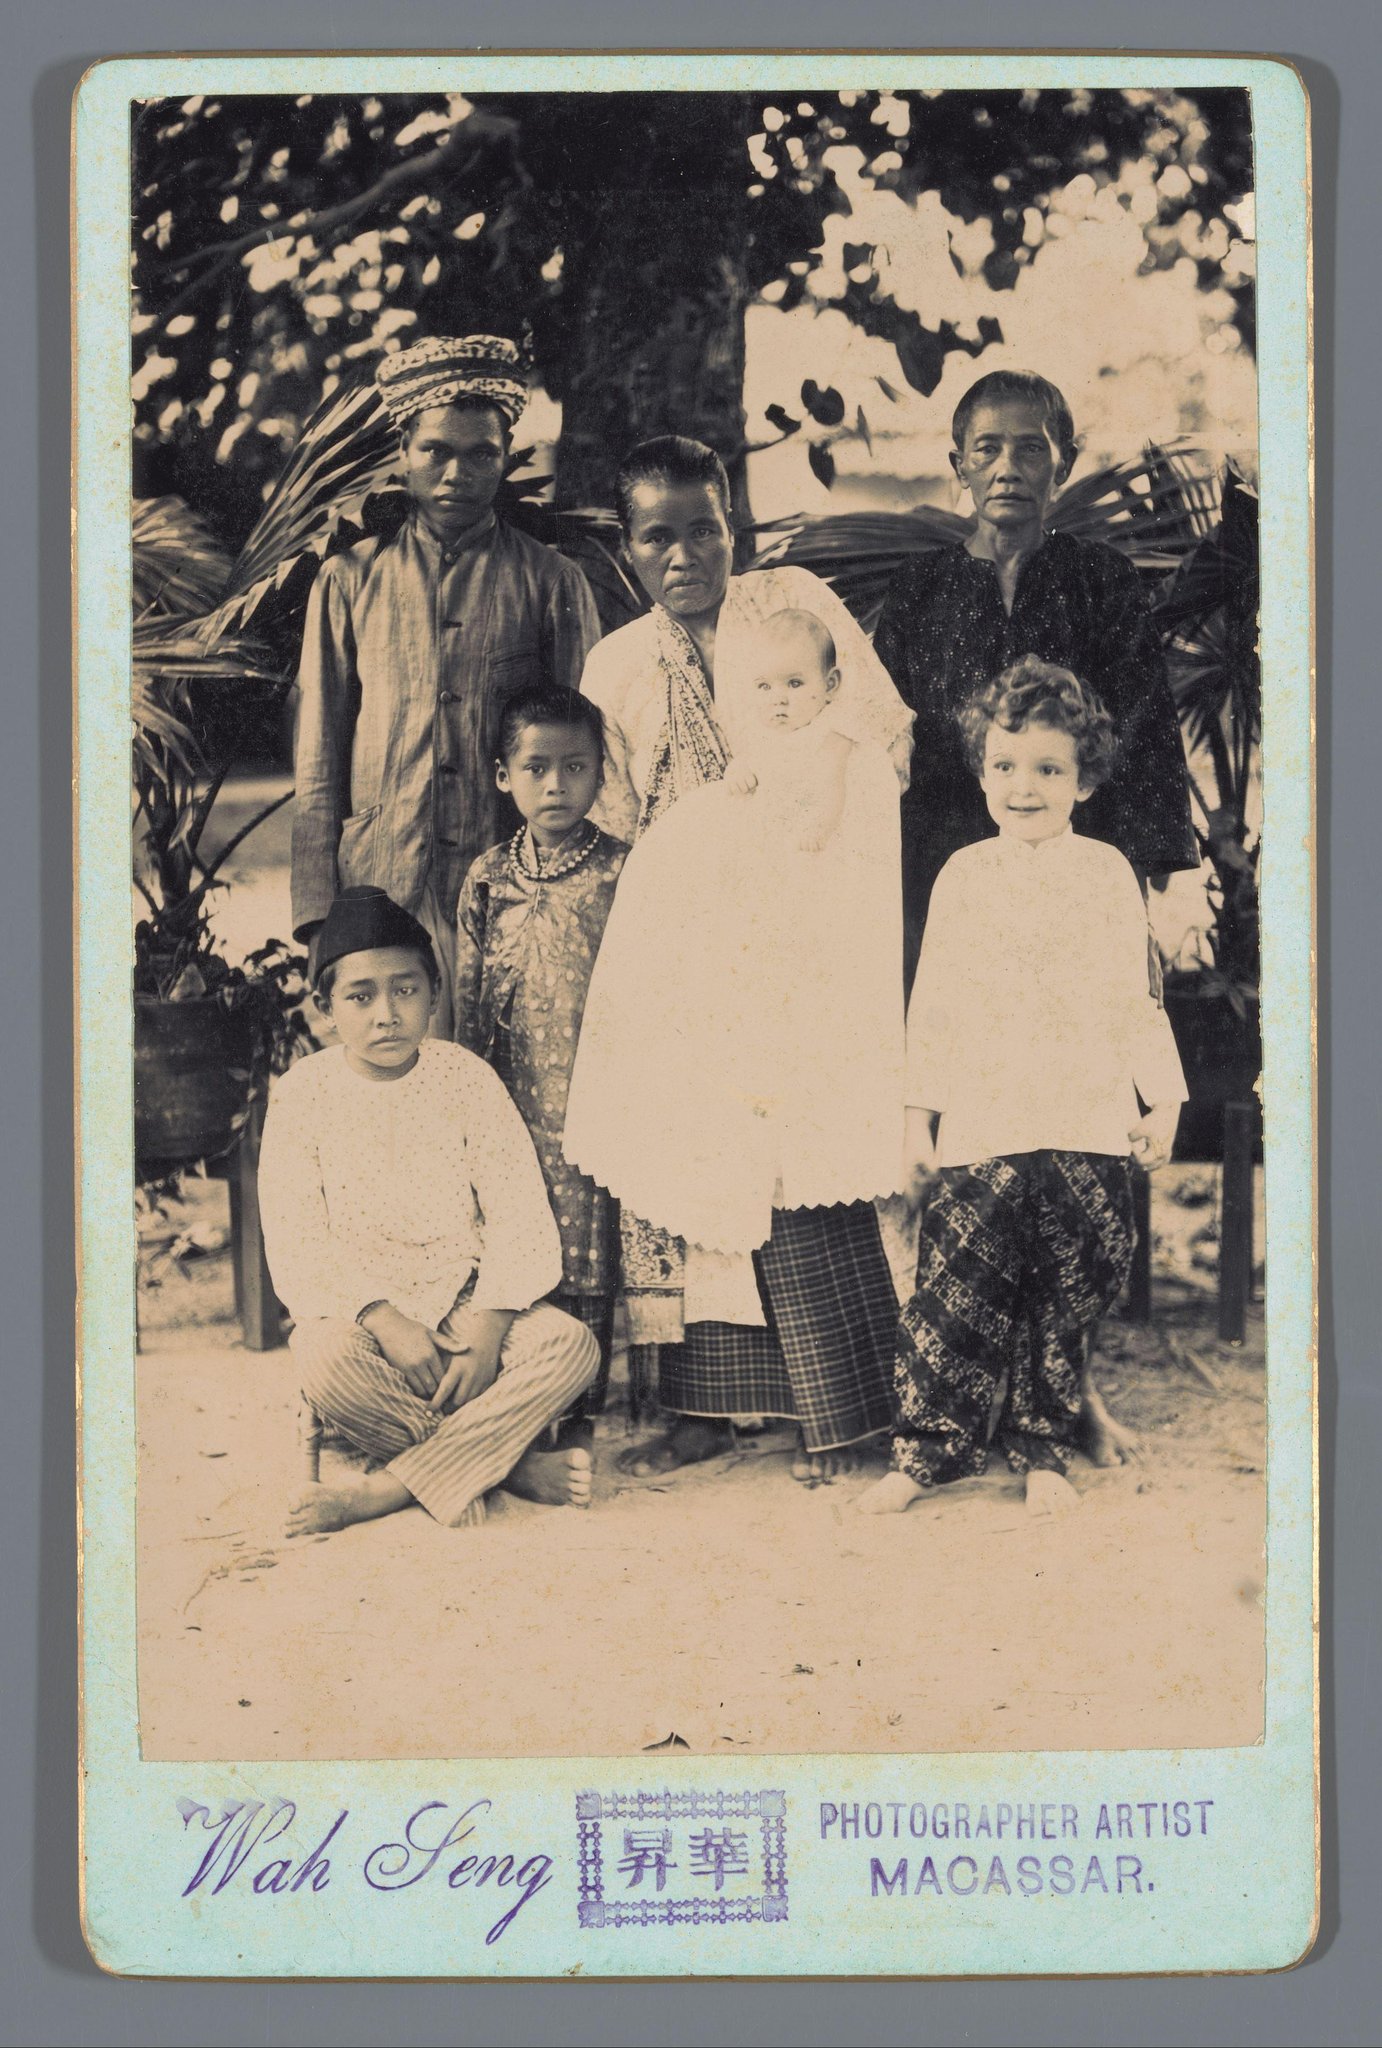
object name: cabinet photograph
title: Portret van een onbekende Indische familie en twee onbekende Westerse kinderen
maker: wah seng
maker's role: fotograaf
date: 1905-1920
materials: cardboard, photographic support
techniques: gelatin silver print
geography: makassar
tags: child, anonymous historical persons portrayed in a group, in a group-portrait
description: Illustratie van een vrouw met een kaart in de hand en een landschap op verso.